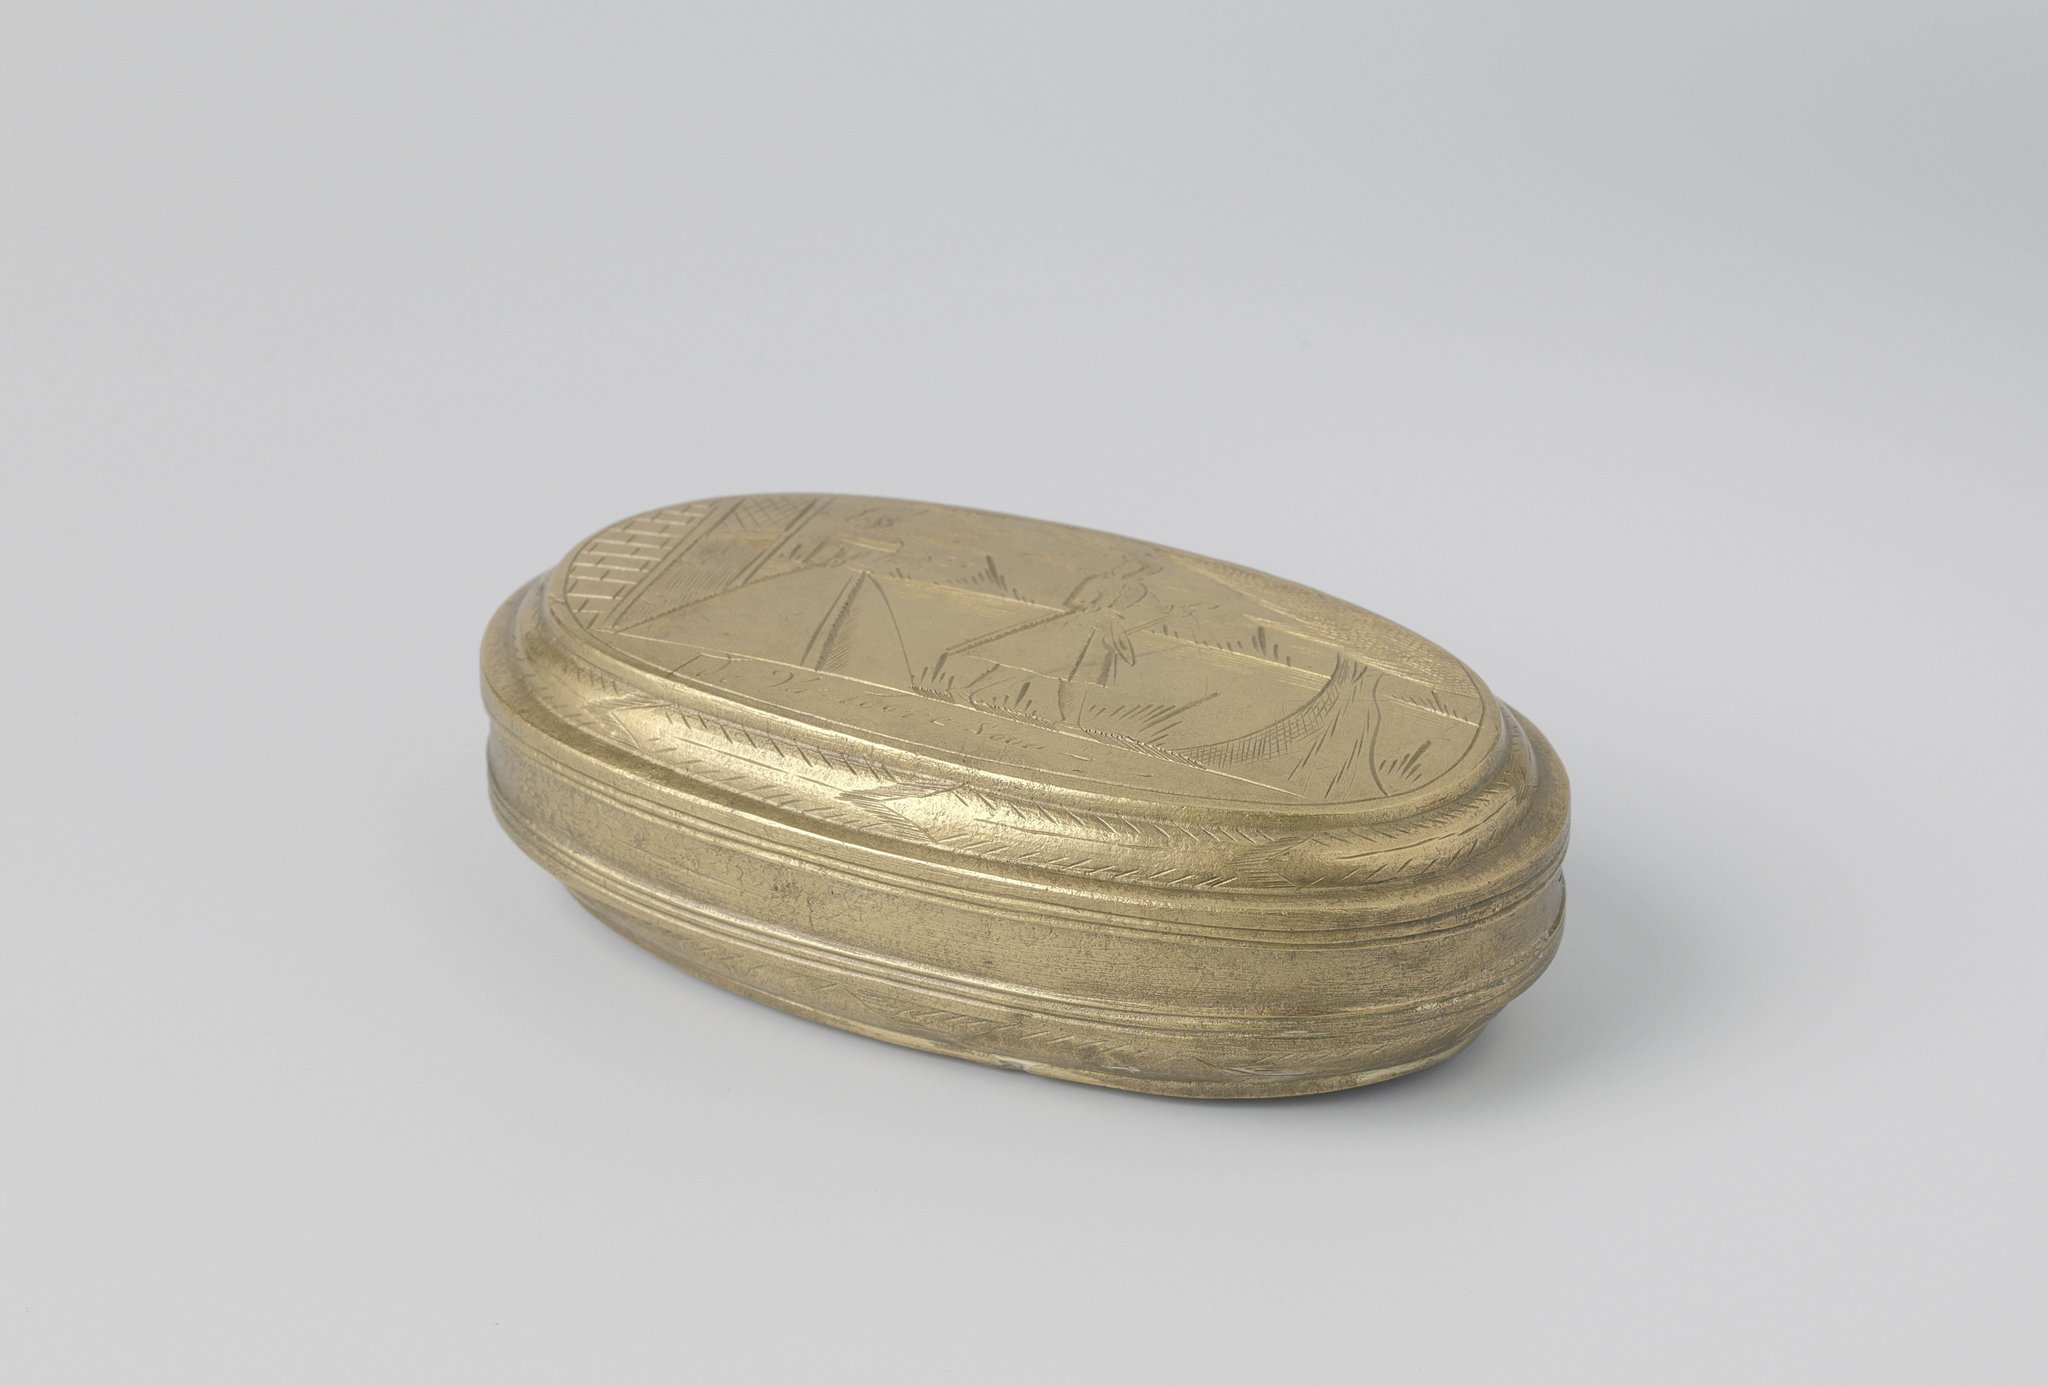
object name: tobacco box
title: Brass tobacco box with engraved scenes of the Prodigal Son from the wreck of the Dutch East Indiaman Hollandia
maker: Anonymous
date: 1700-1743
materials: copper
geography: netherlands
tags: verenigde oostindische compagnie, hollandia (schip), annet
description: Tobacco box; box with lid, oval, flat, domed, moulded rim, both sides engraved with scenes of the Prodigal Son (inscriptions: lid [de verloore soon], underside [al verteert]), applied five-lugged hinge.